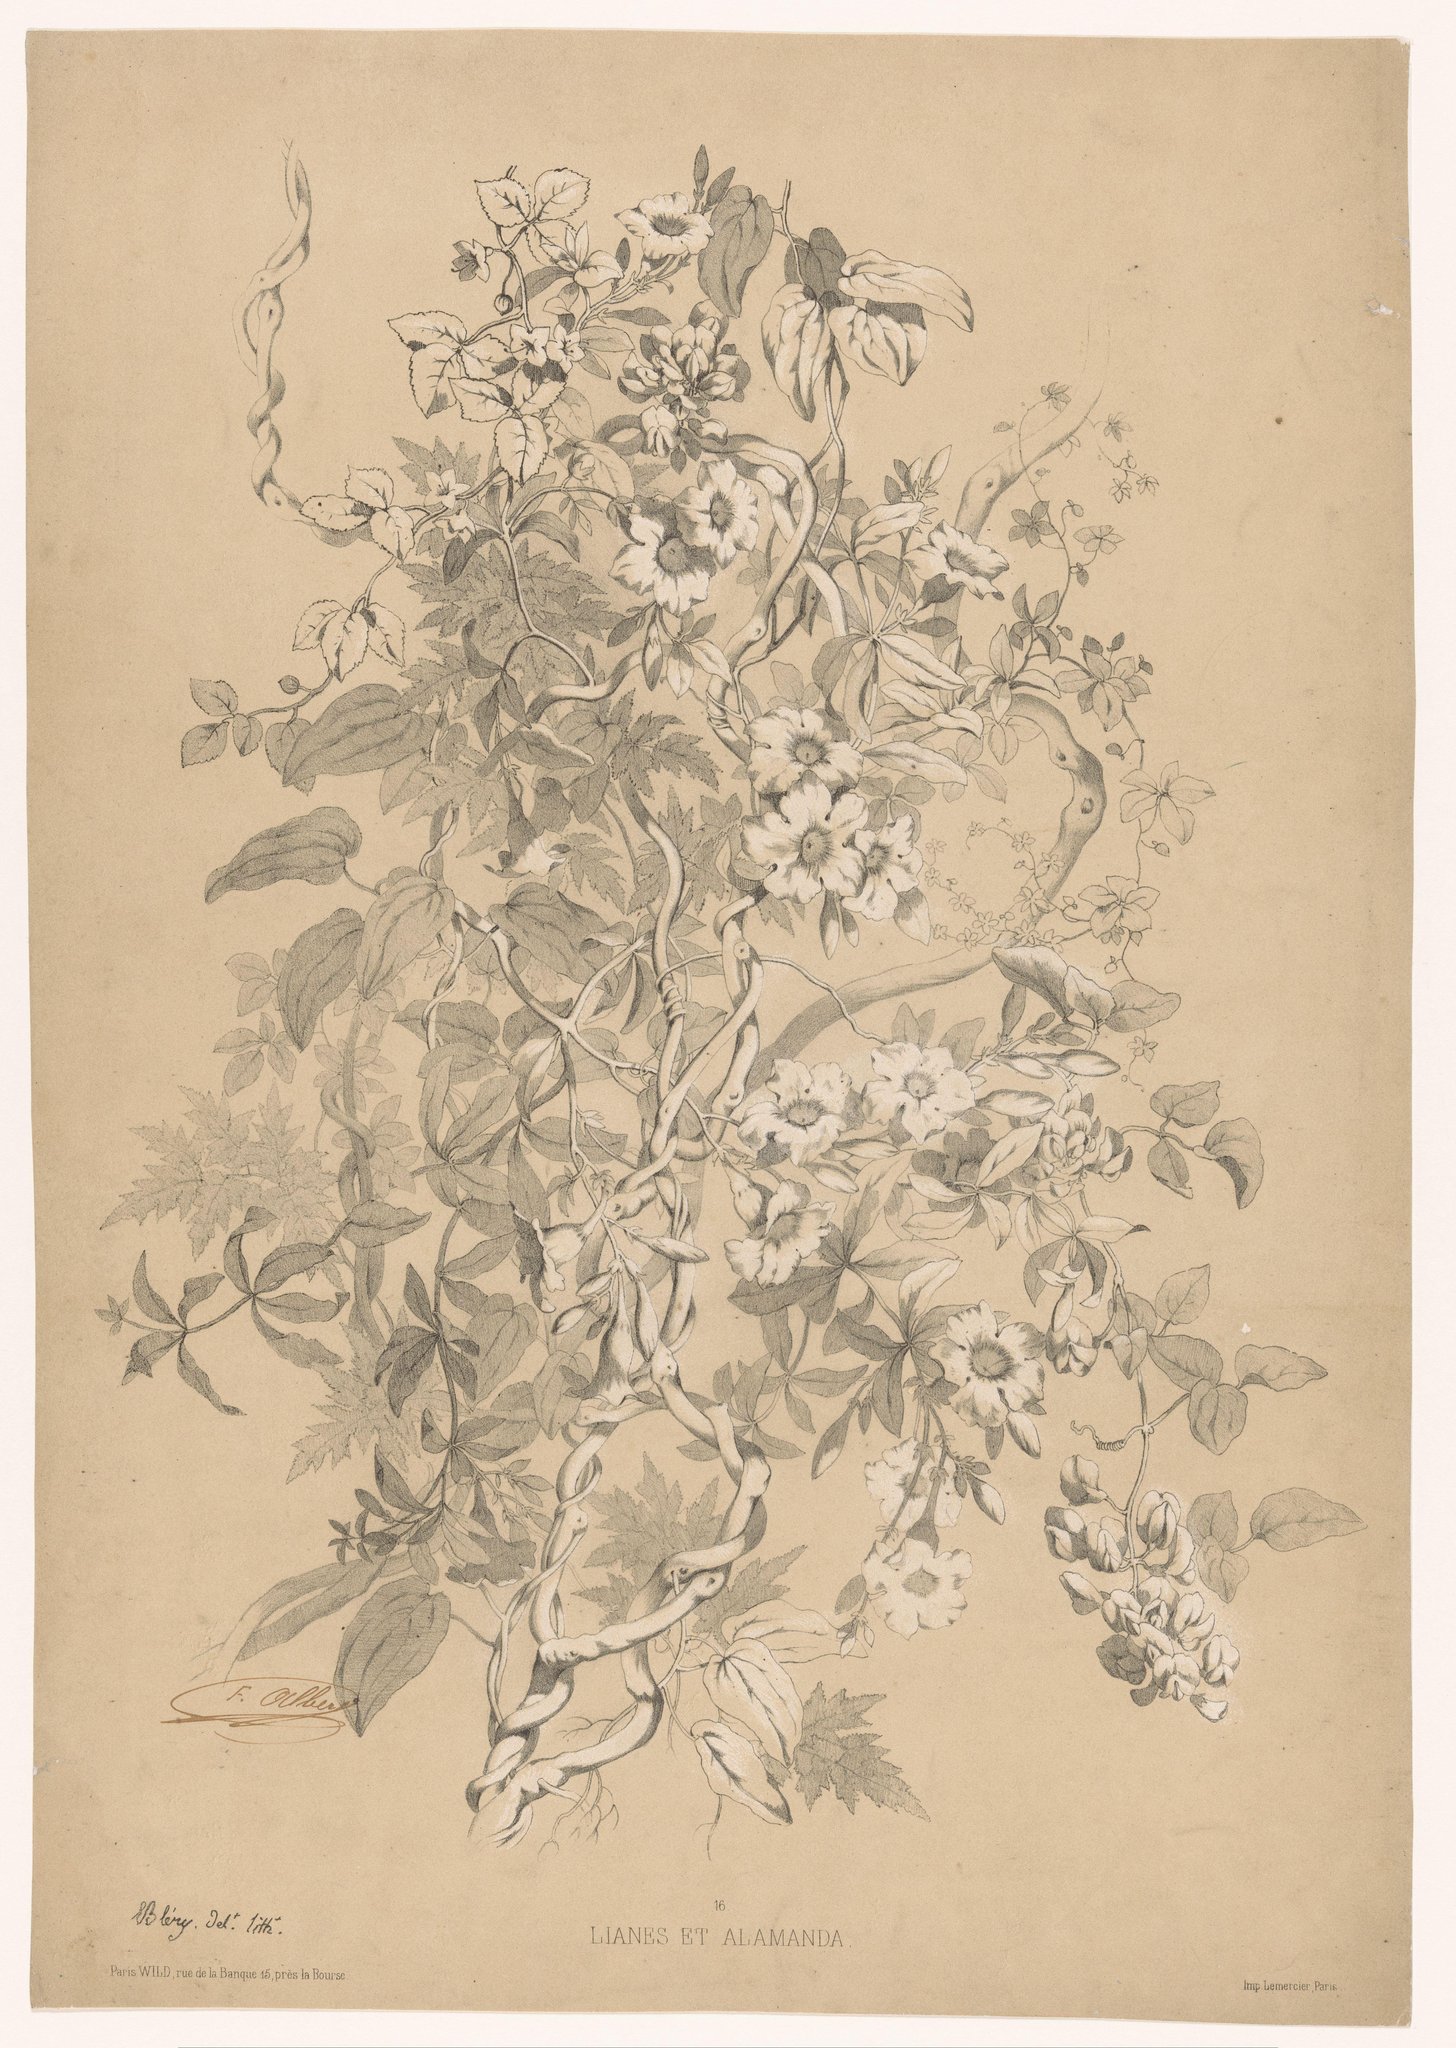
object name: print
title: Planten en bloemen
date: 1853-1858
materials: paper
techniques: tone lithography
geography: paris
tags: flowers, plants and herbs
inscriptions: annotation: ‘F. Albers’, collector's mark: Lugt 2228, collector's mark: Lugt 2760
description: De serie Guide industriel dessiné d'après nature et lithographié par Bléry is uitgegeven in verschillende livraisons tussen 1853 en 1858.